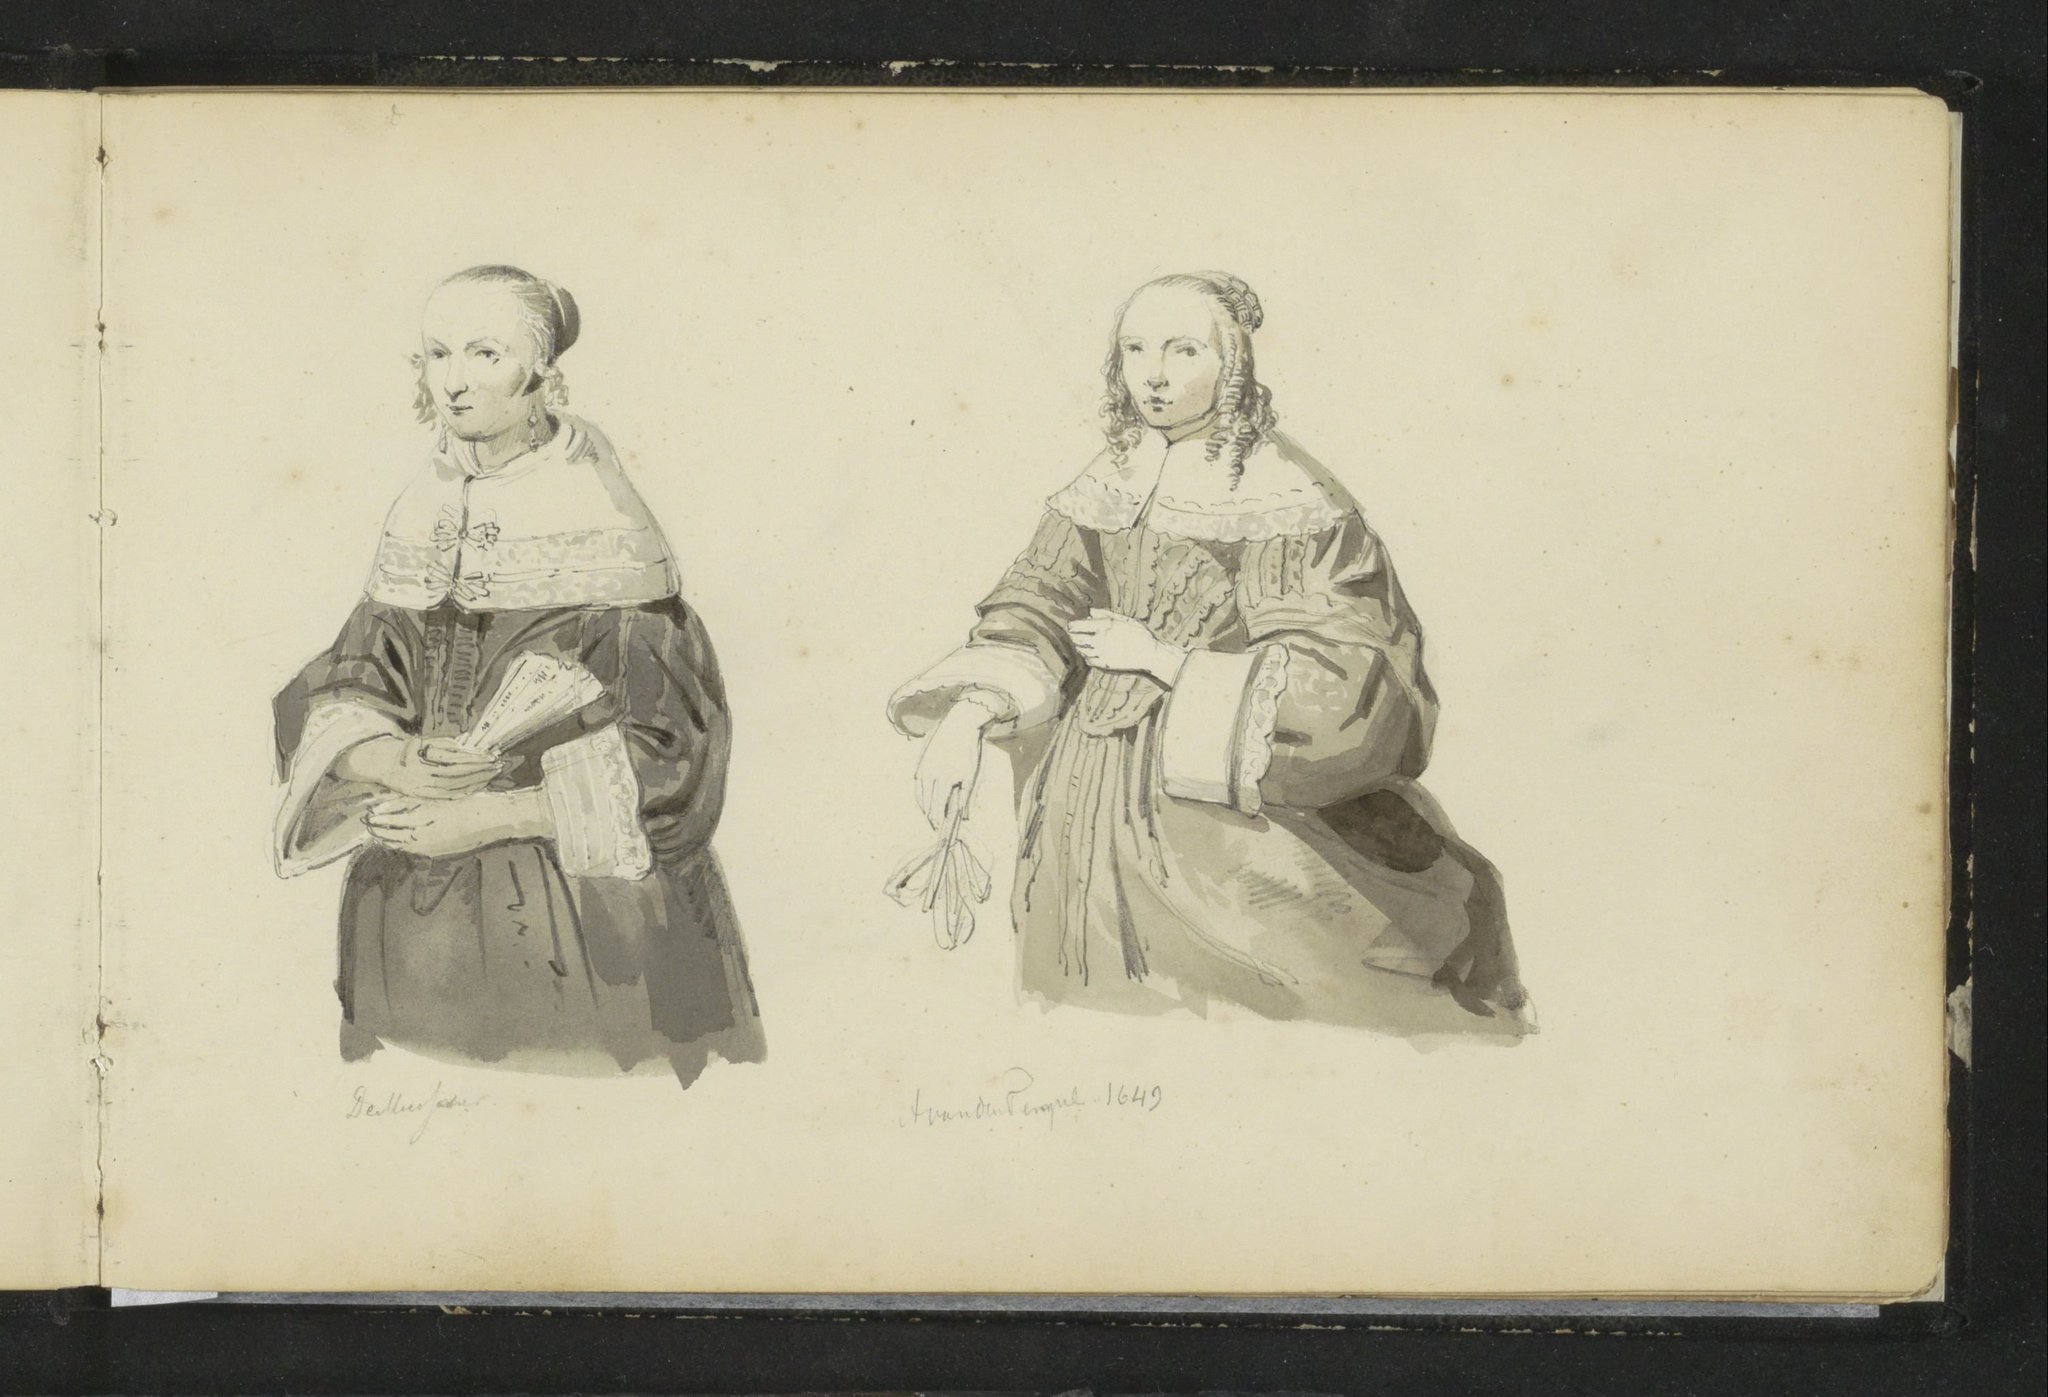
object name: sketchbook leaf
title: Twee vrouwenportretten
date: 1846-1882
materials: paper, pencil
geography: low countries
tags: anonymous historical person portrayed - bb - woman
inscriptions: annotation: ‘Demusscher[?]/ A. van den Tempel 1649’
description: Links een portret van een vrouw in zeventiende-eeuwse kleding met een waaier. Rechts een portret van een vrouw in zeventiende-eeuwse kleding, mogelijk ook met een waaier. Blad 4 uit een schetsboek met 91 bladen.